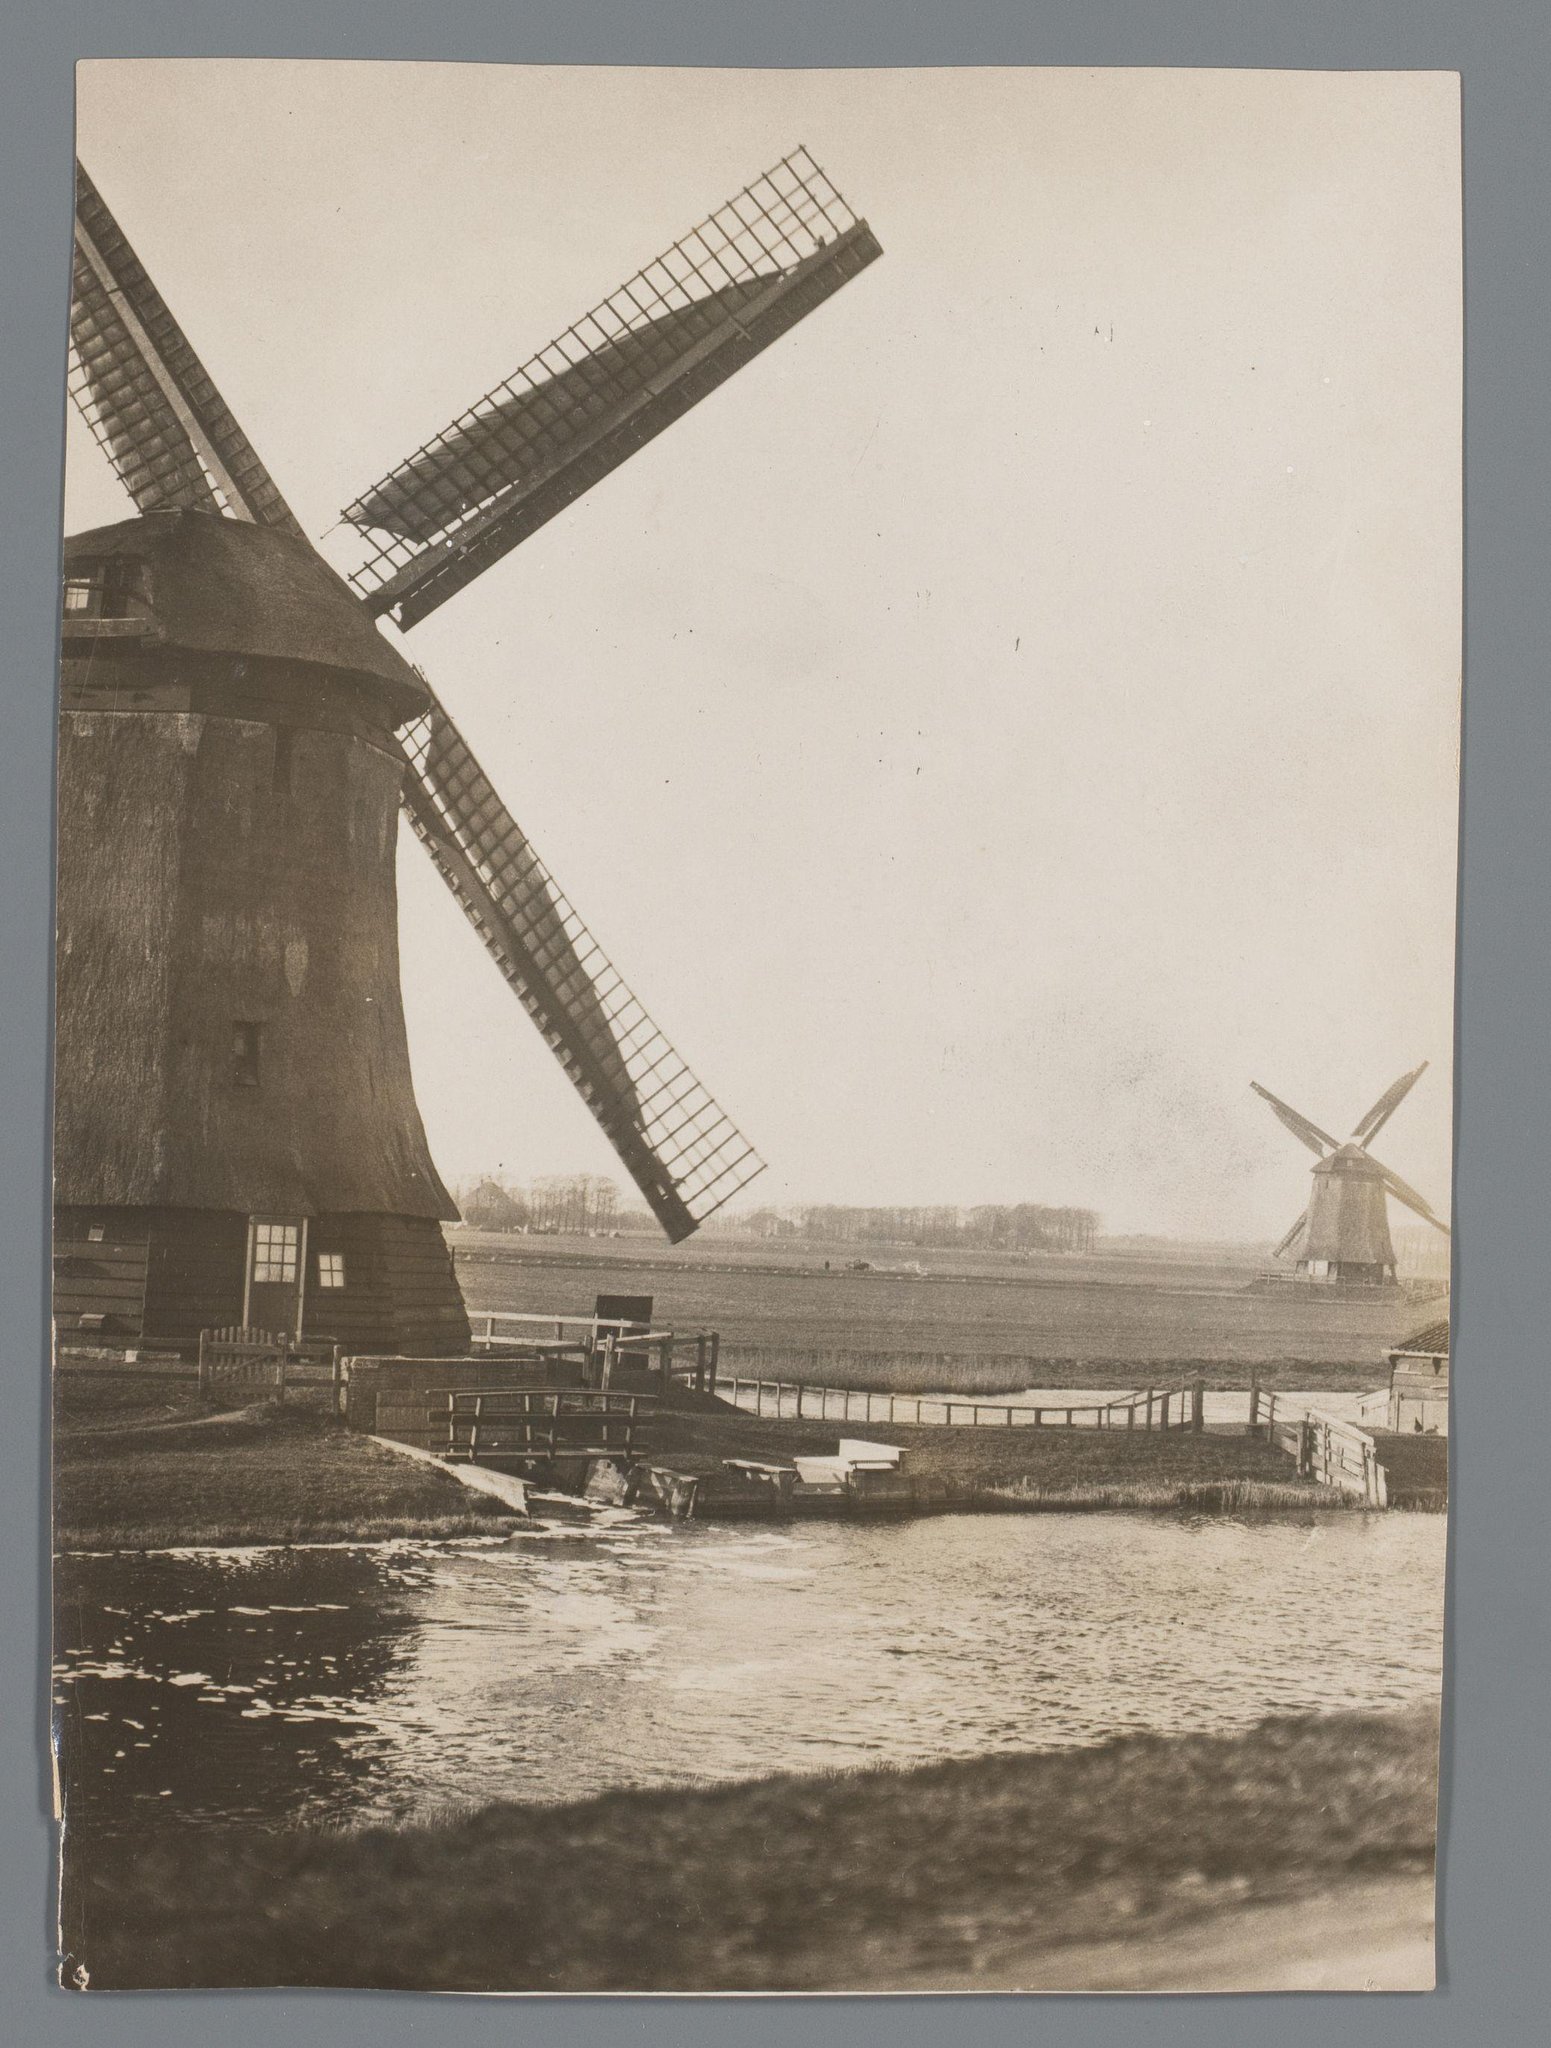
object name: photograph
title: Watermolens in de Schermerpolder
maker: Anonymous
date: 1900-1929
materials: paper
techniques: gelatin silver print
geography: schermerhorn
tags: windmill in landscape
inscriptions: inscription: ‘€ 6,50/ g 11’, copyright notice: ‘N NEDERLANDSCH FOTO-BUREAU/ F B "POLYGOON"/ HAARLEM - - KOUDENHORN 8/ No. Voor nabestelling van/ deze foto nevenstaand/ nummer op te geven./ -- COPYRIGHT --’